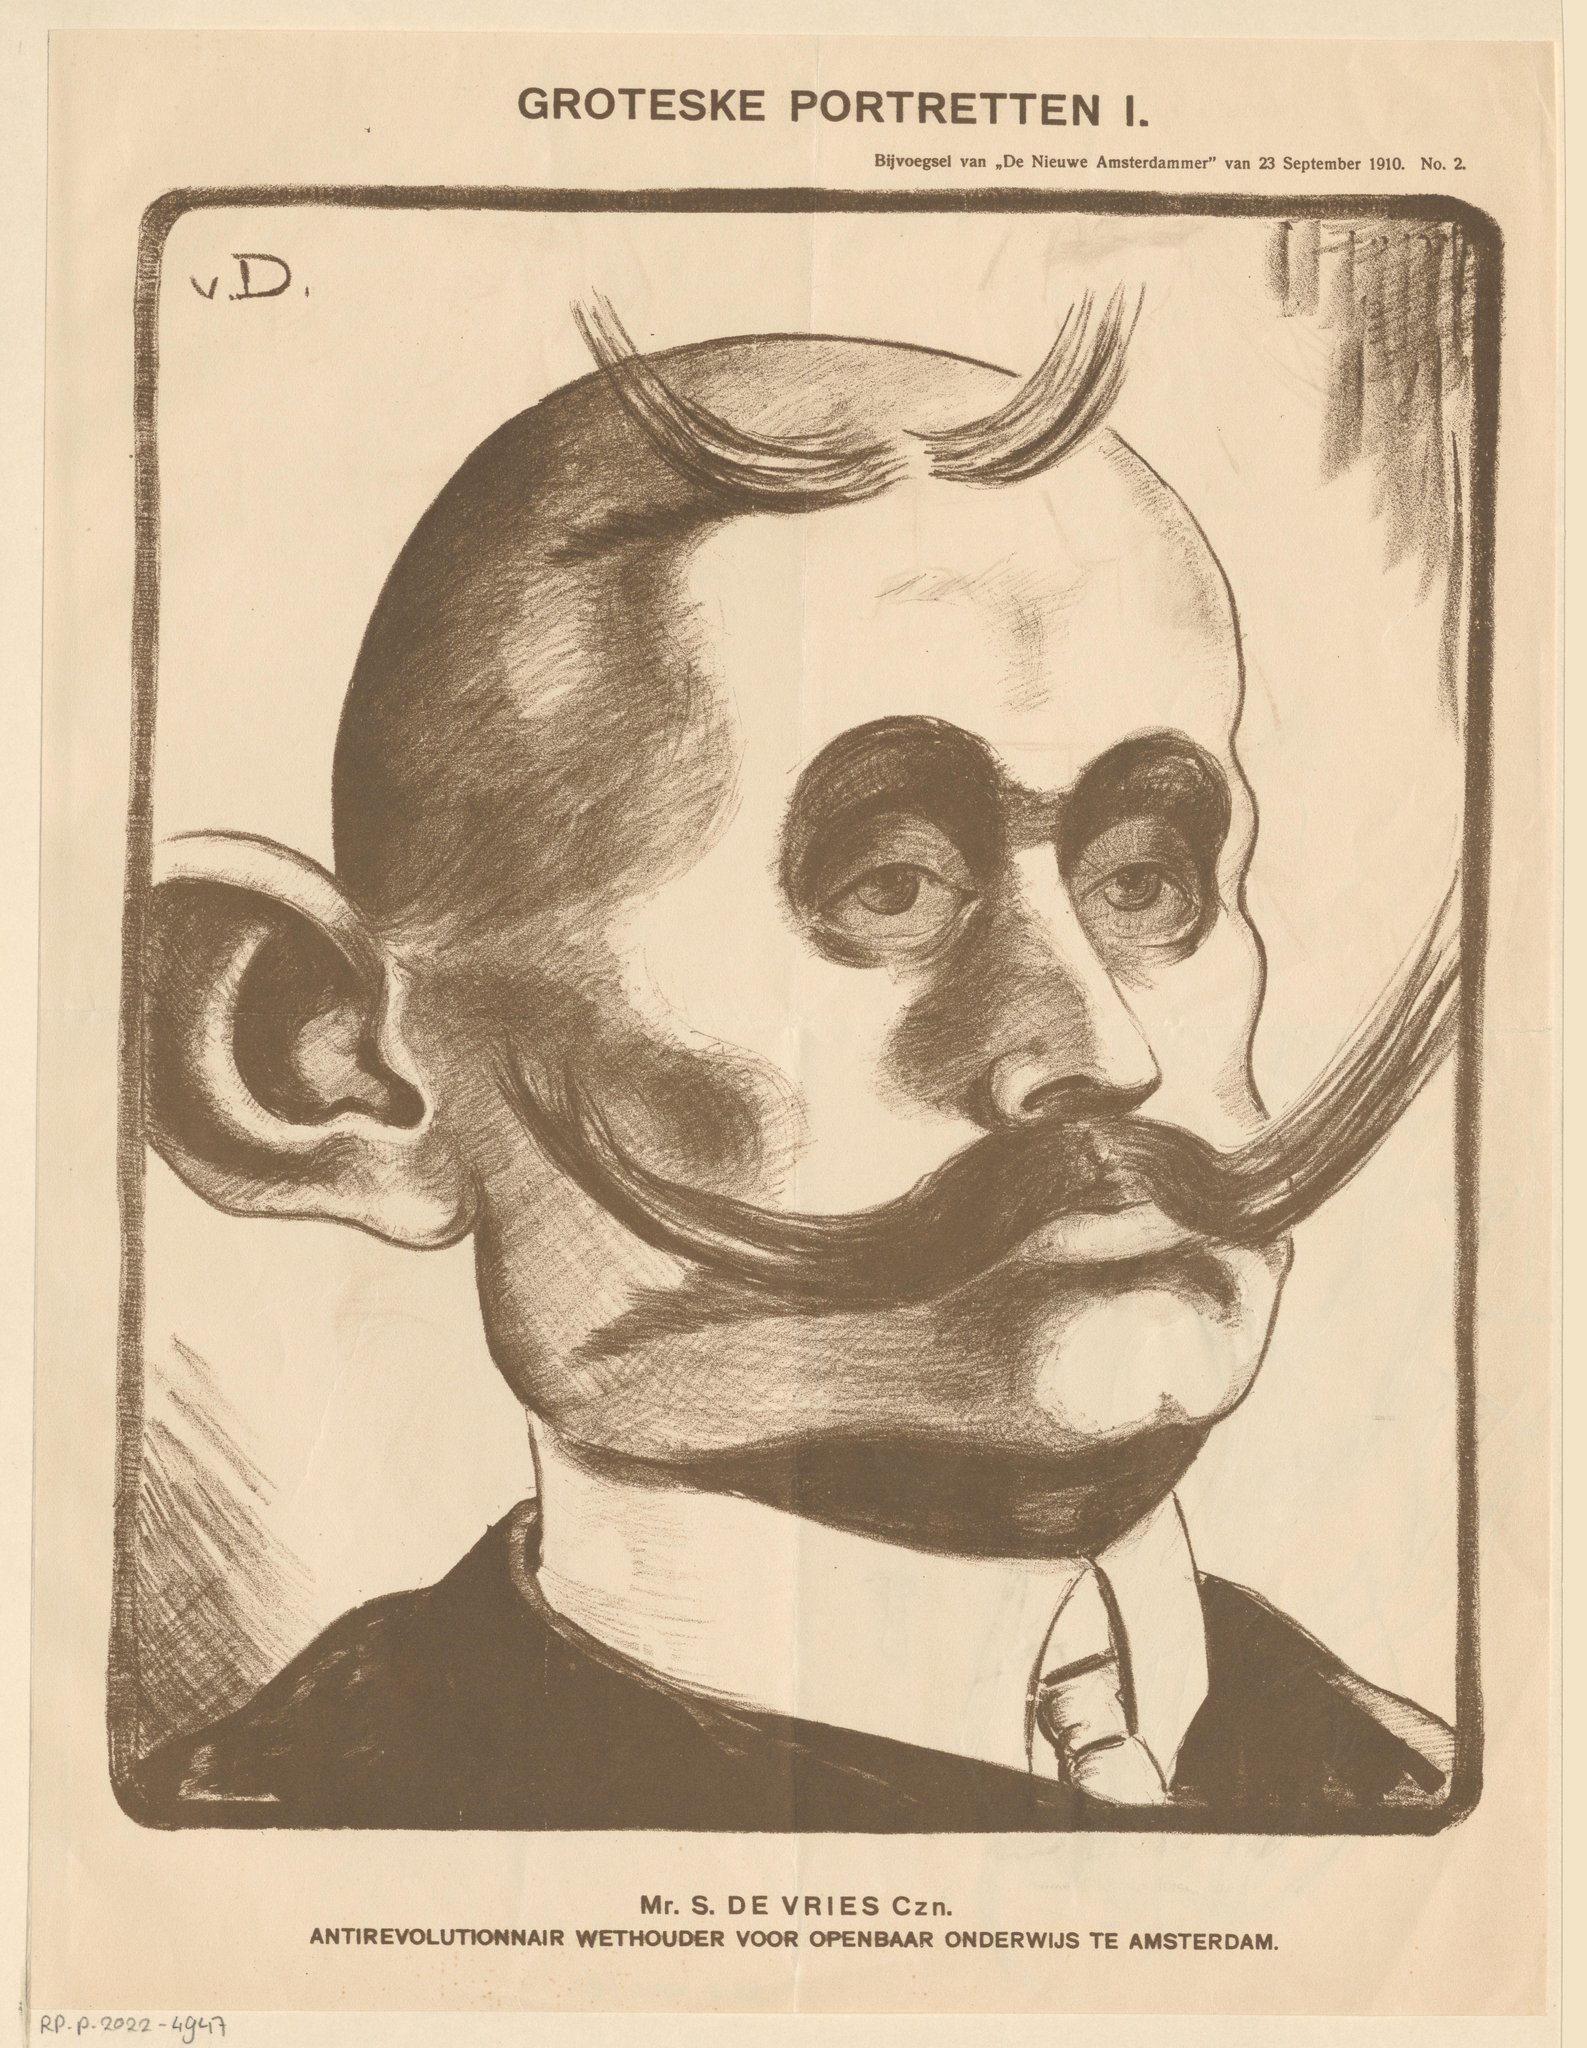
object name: print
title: Karikatuur van Simon Czn. de Vries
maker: theo van doesburg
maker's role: draughtsman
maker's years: 1883-1931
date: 1910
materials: paper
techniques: lithograph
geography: netherlands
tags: politician, historical persons, politician, e.g. party leader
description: Deze prent werd uitgegeven als bijvoegsel van De Amsterdammer op 23 september 1910.